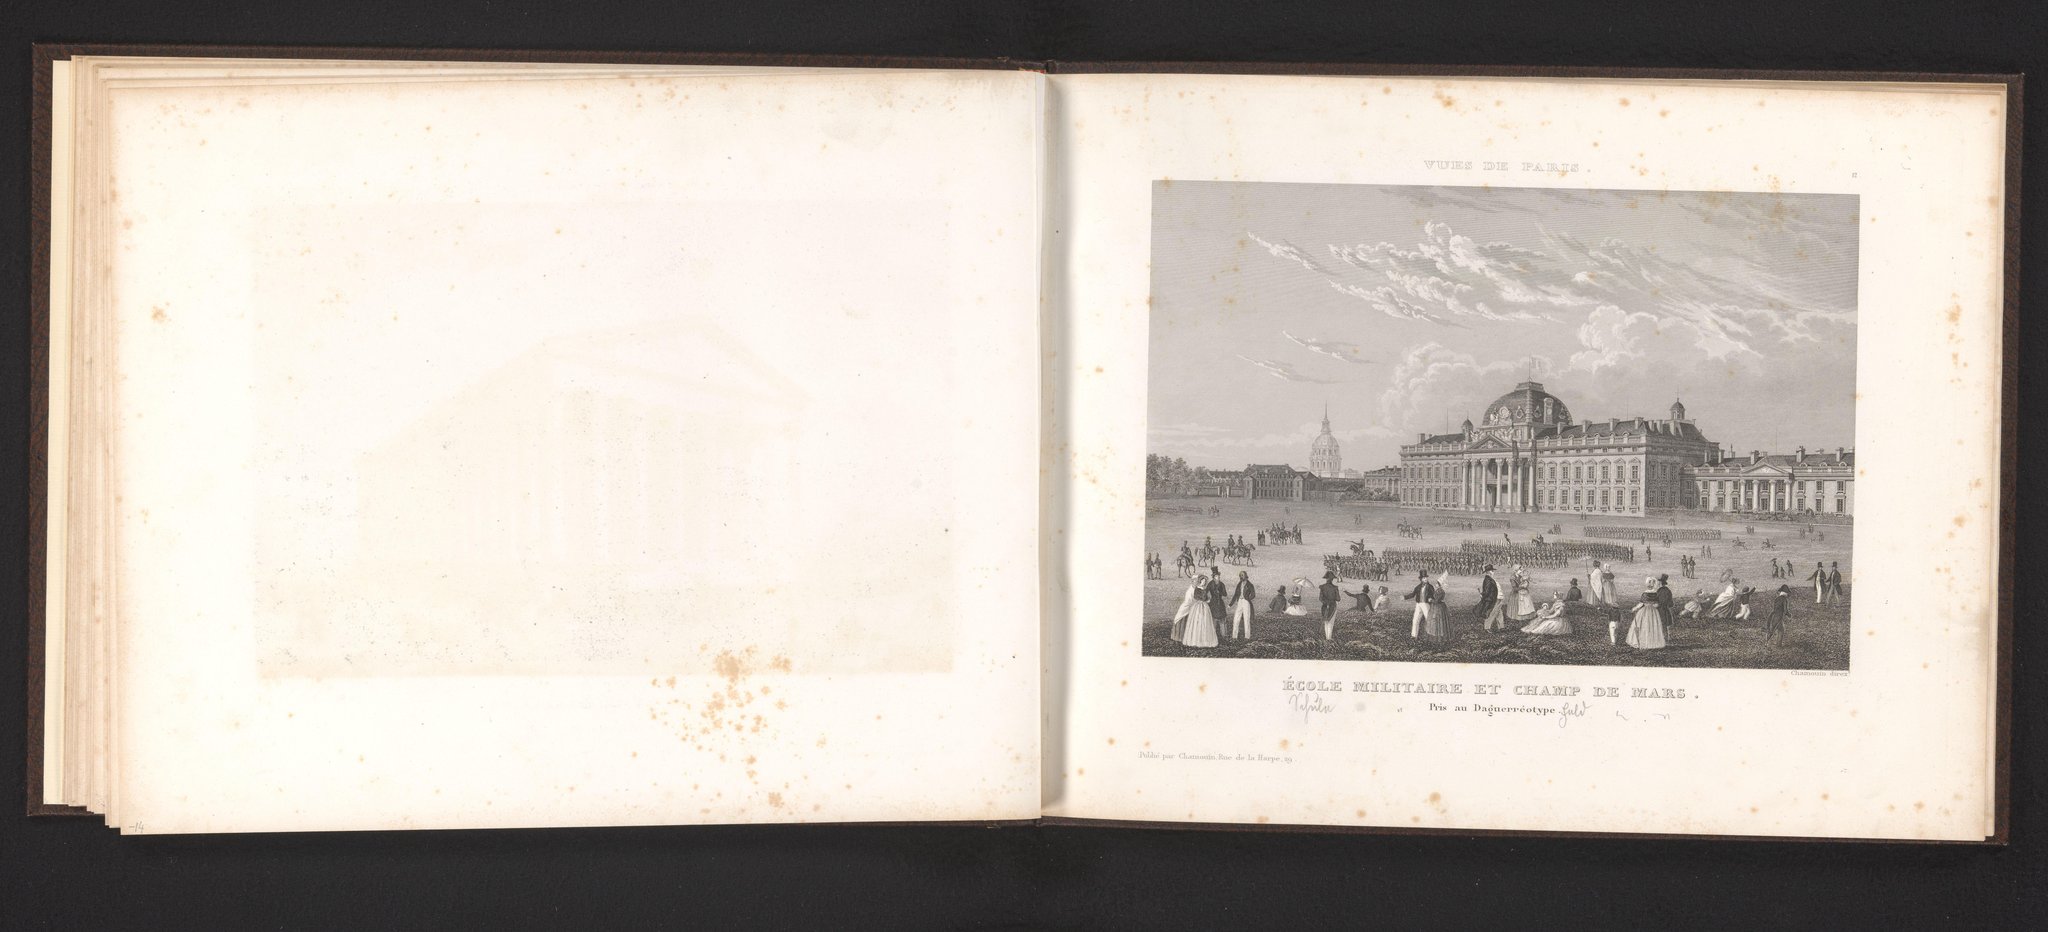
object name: page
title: Vues de Paris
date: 1845-1850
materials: paper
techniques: engraving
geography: paris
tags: military academy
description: Prent op vijftiende ongenummerde pagina na titelpagina. Prent gemaakt naar daguerreotypie.